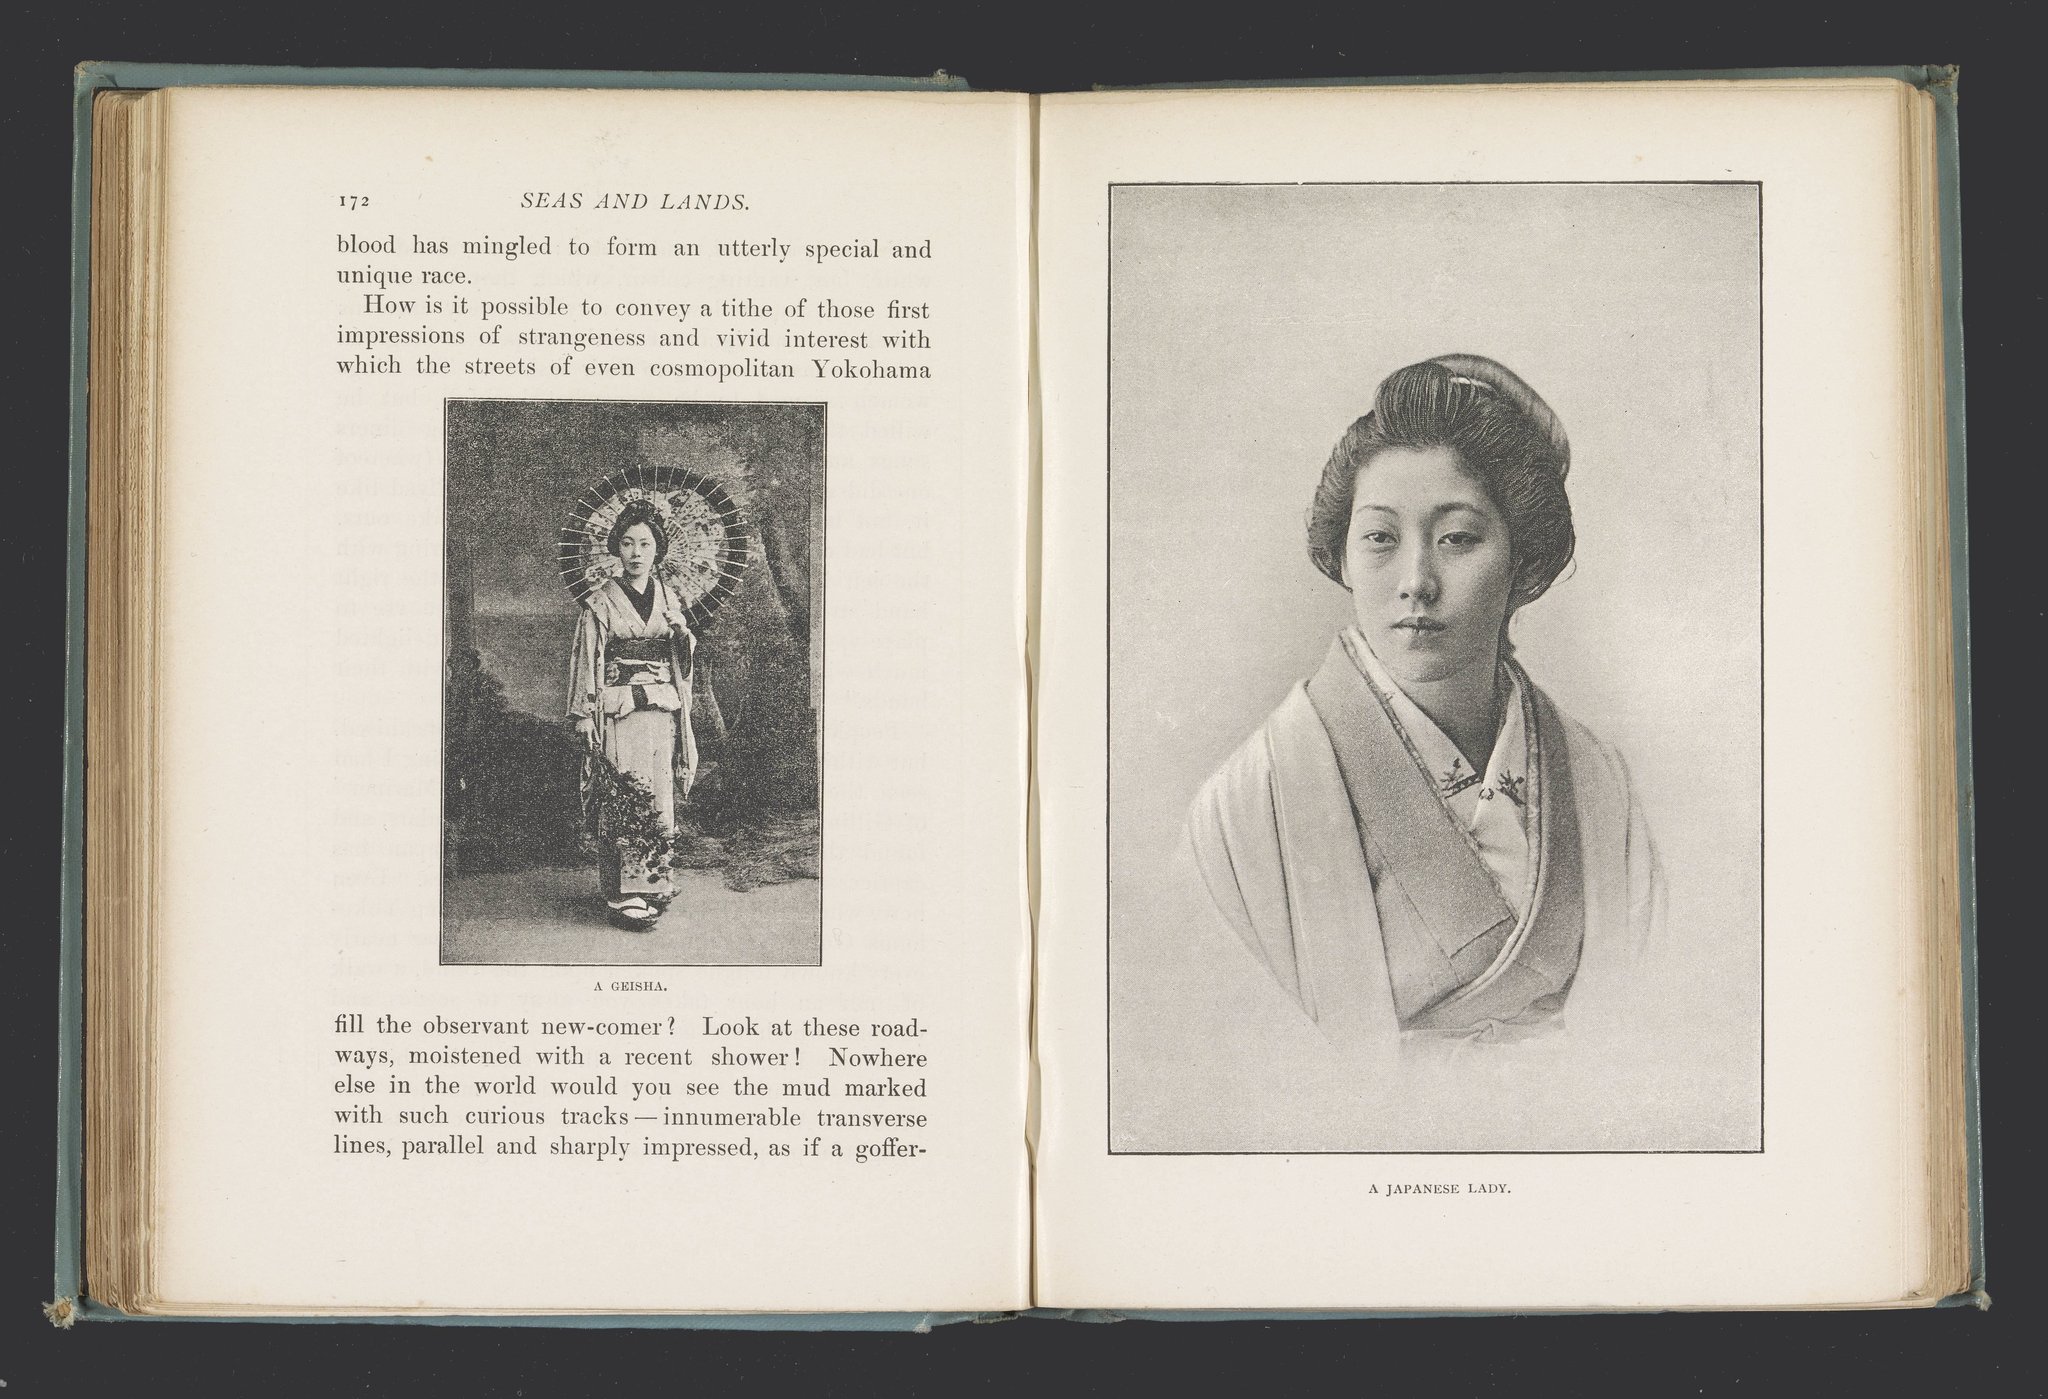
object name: photomechanical print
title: A Geisha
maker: Anonymous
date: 1882-1892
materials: paper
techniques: autotype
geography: japan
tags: adult woman, folk costume, regional costume